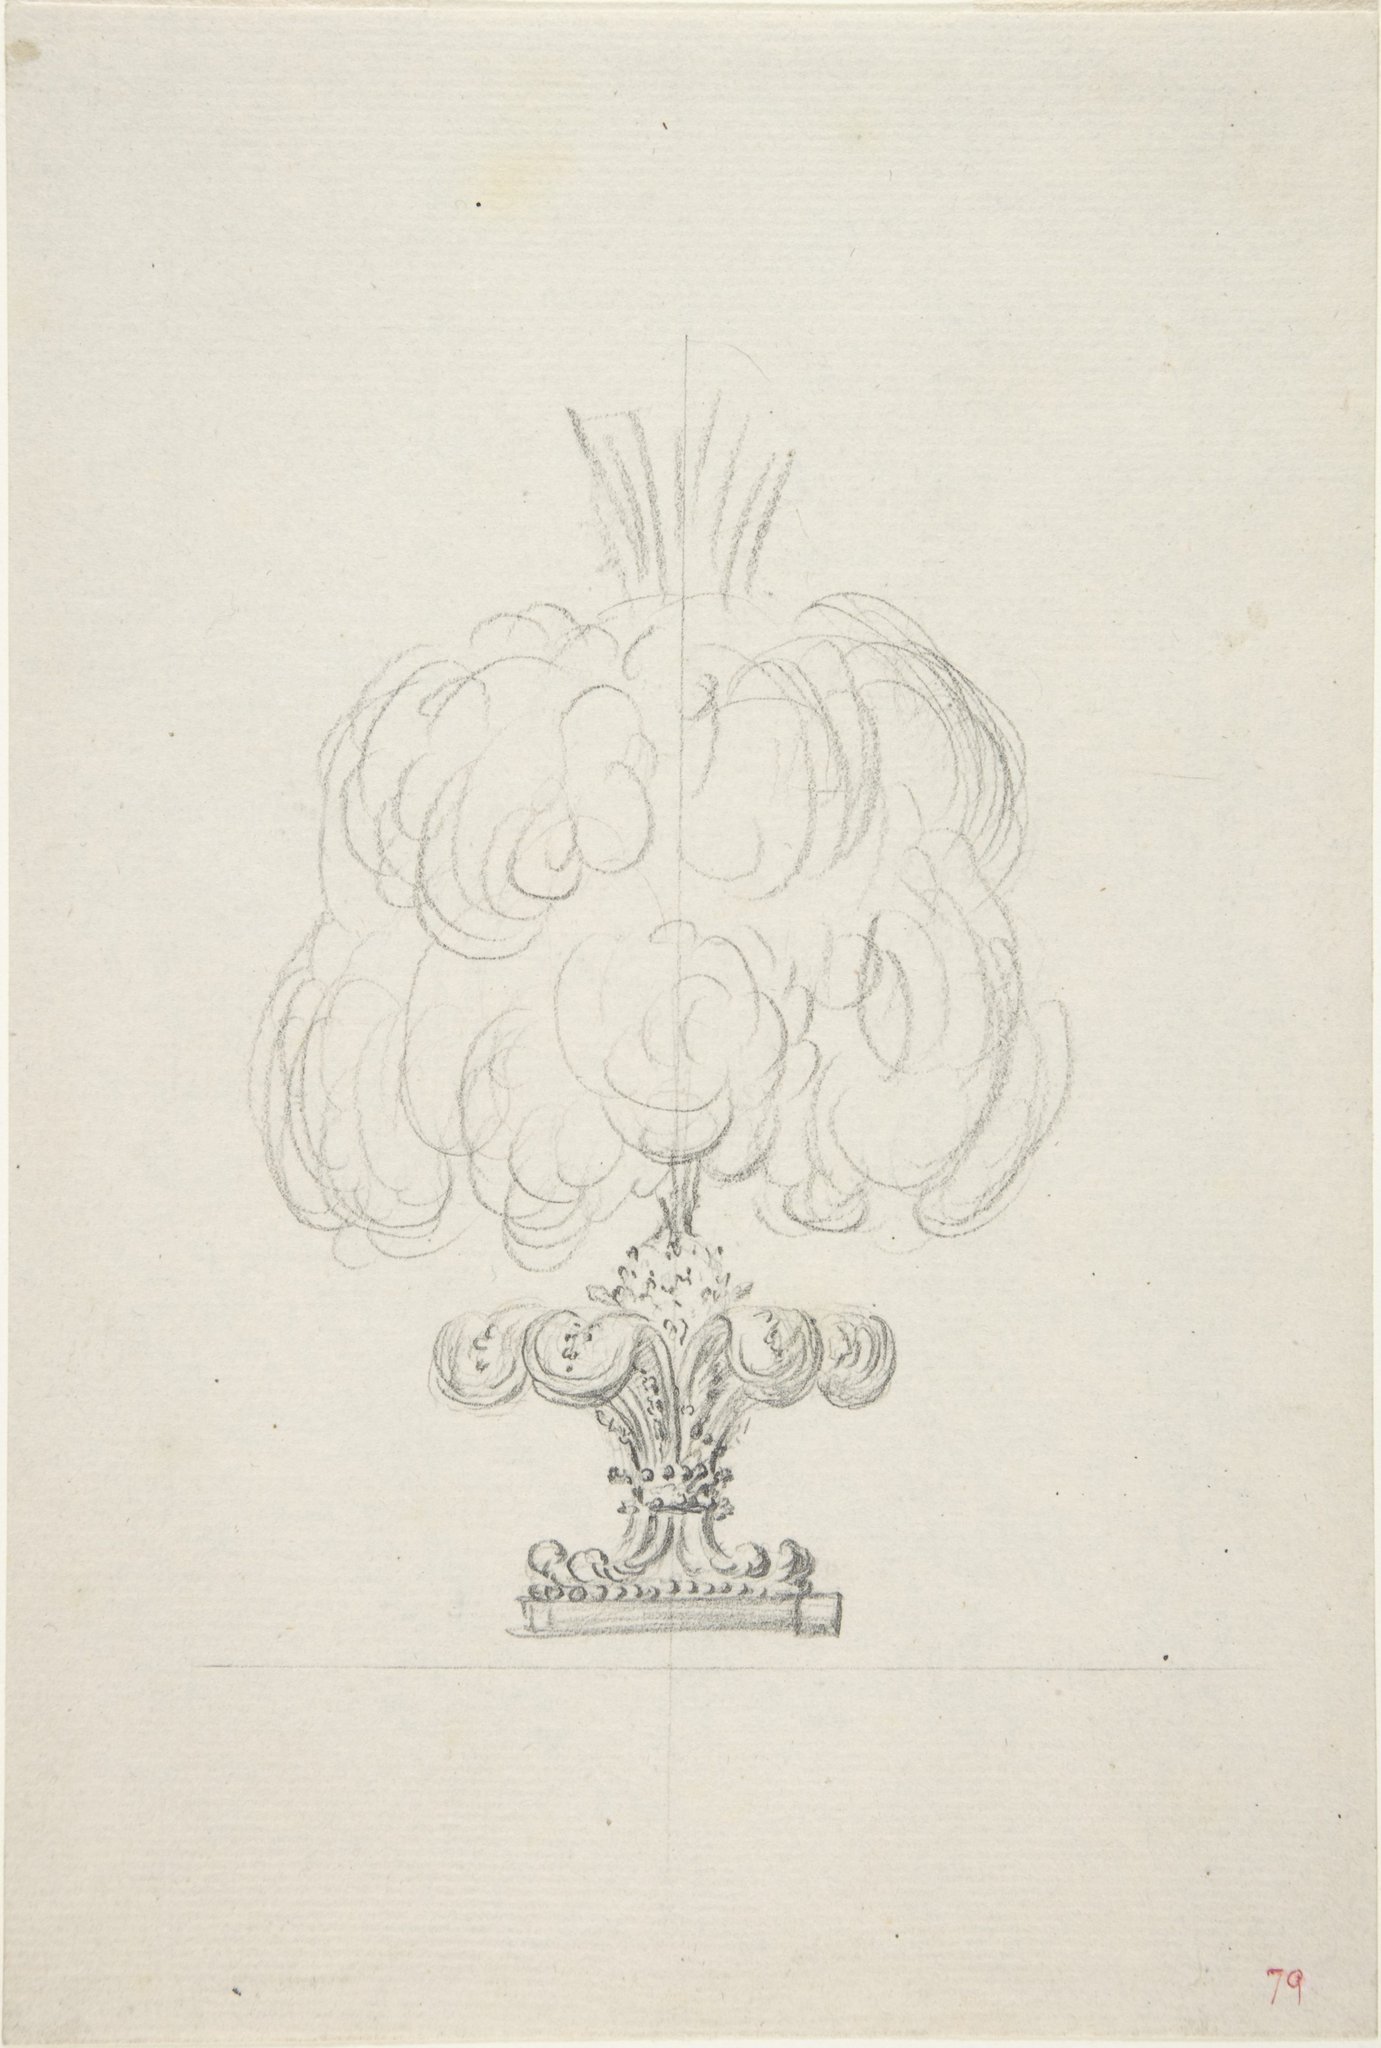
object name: drawing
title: Design for a Plumed Oil Lamp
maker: anonymous, french, 18th century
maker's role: artist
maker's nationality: french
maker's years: 1700-1800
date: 1770-1790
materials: graphite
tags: lamps